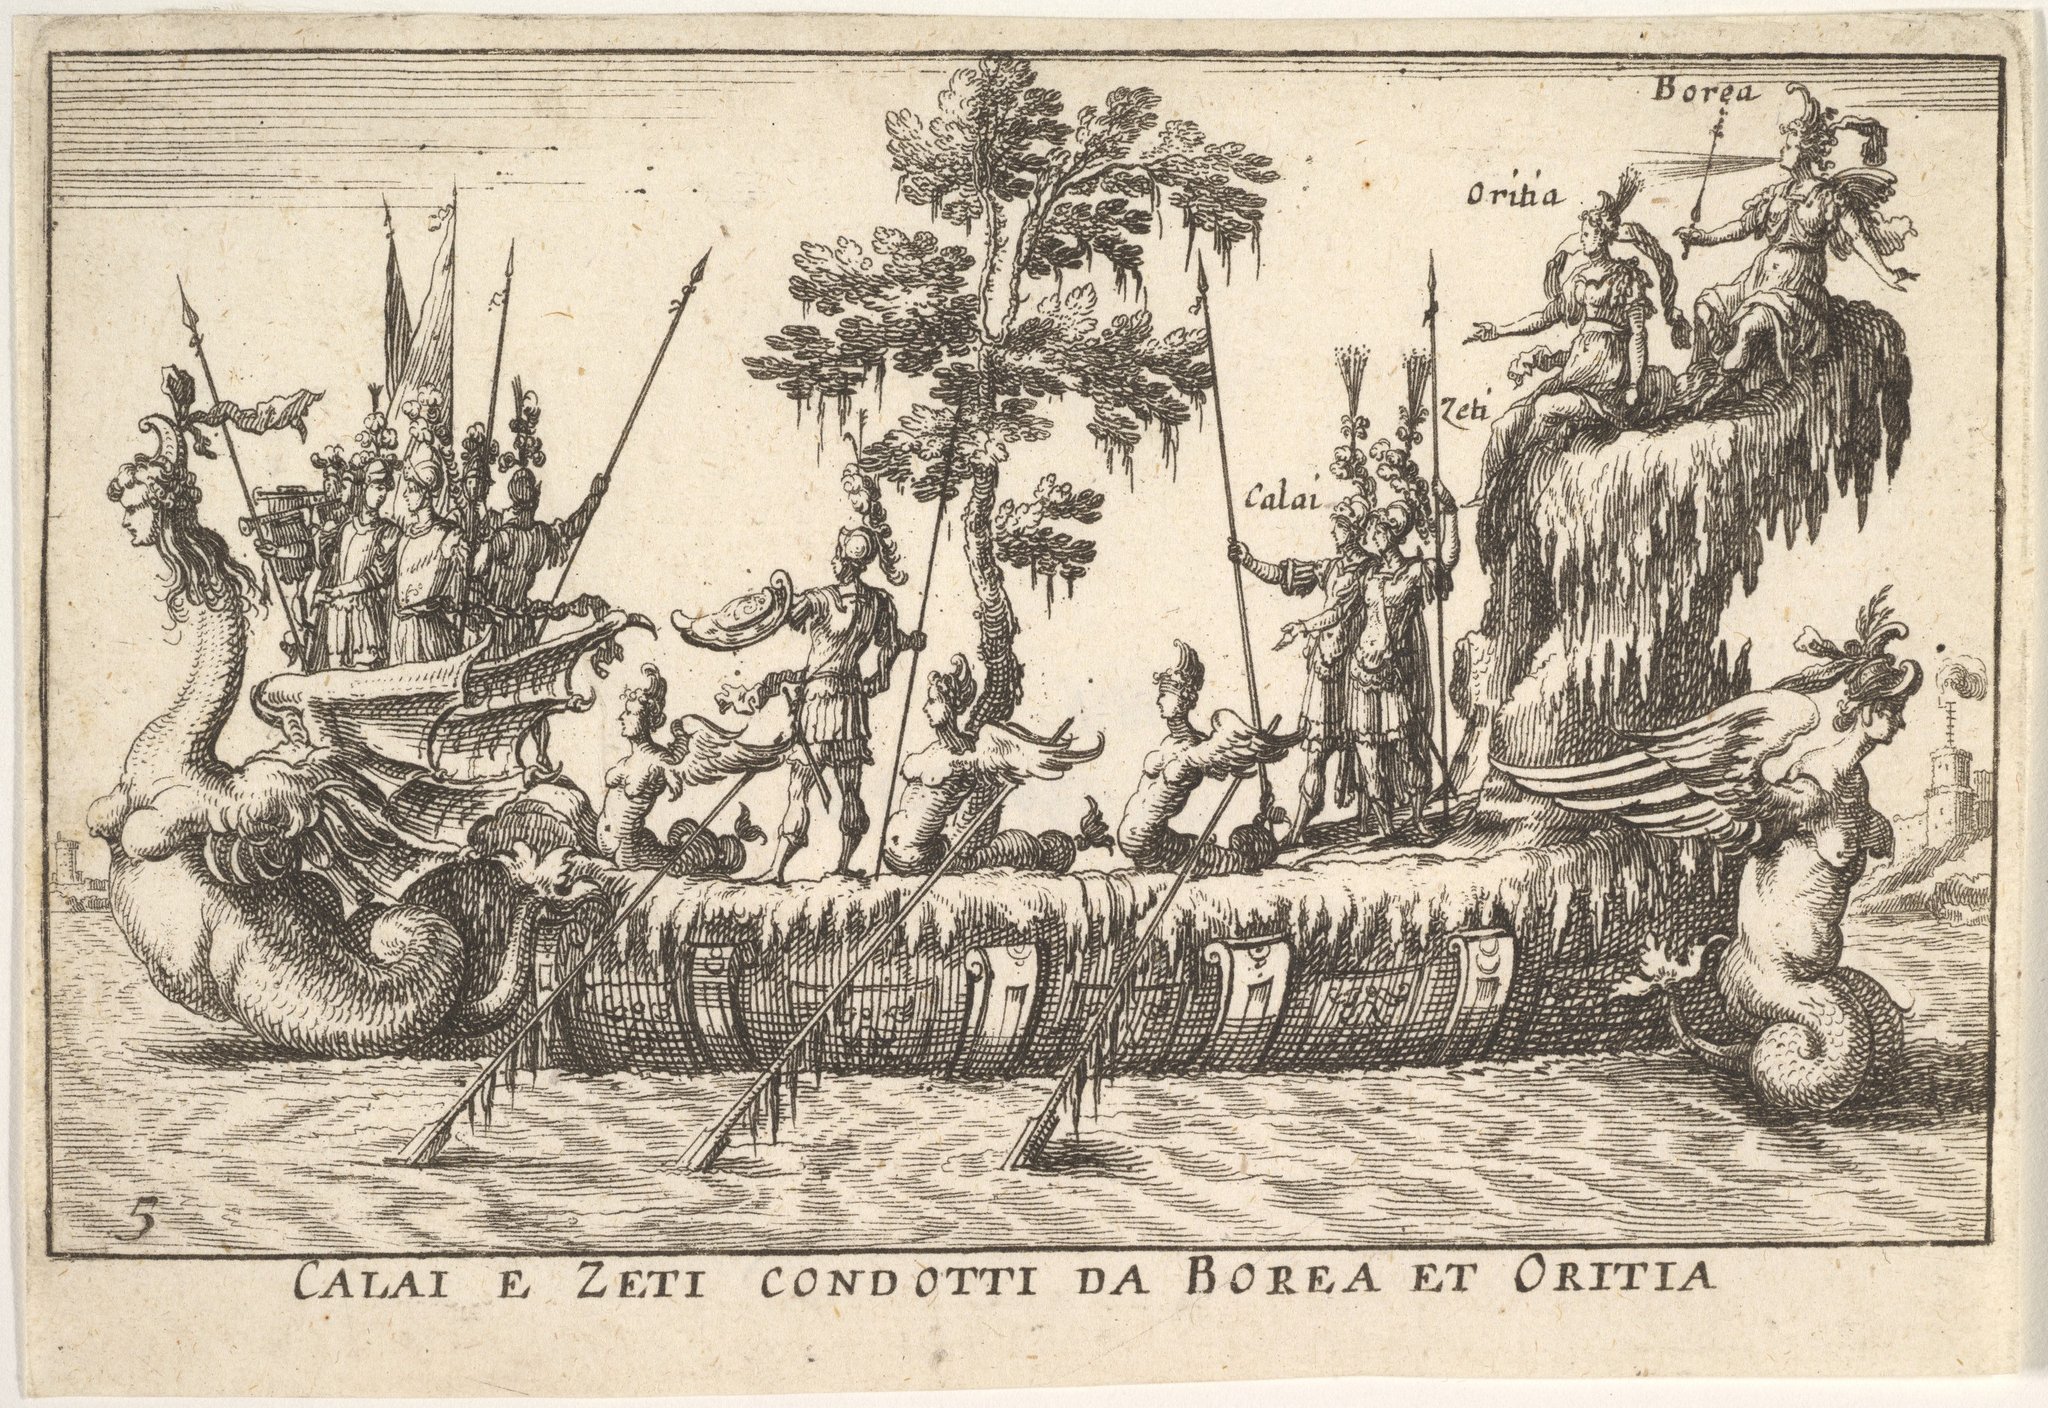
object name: print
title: Calais and Zetes led by Boreas and Oreithyia (Calai e Zeti condotti da Borea et Oritia), from "The magnificent pageant on the river Arno in Florence for the marriage of the Grand Duke" (Le Magnifique carousel fait sur le fleuve de l'Arne a Florence, pour le mariage du Grand Duc)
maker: Anonymous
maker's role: artist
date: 1664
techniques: etching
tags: soldiers,spears,ships